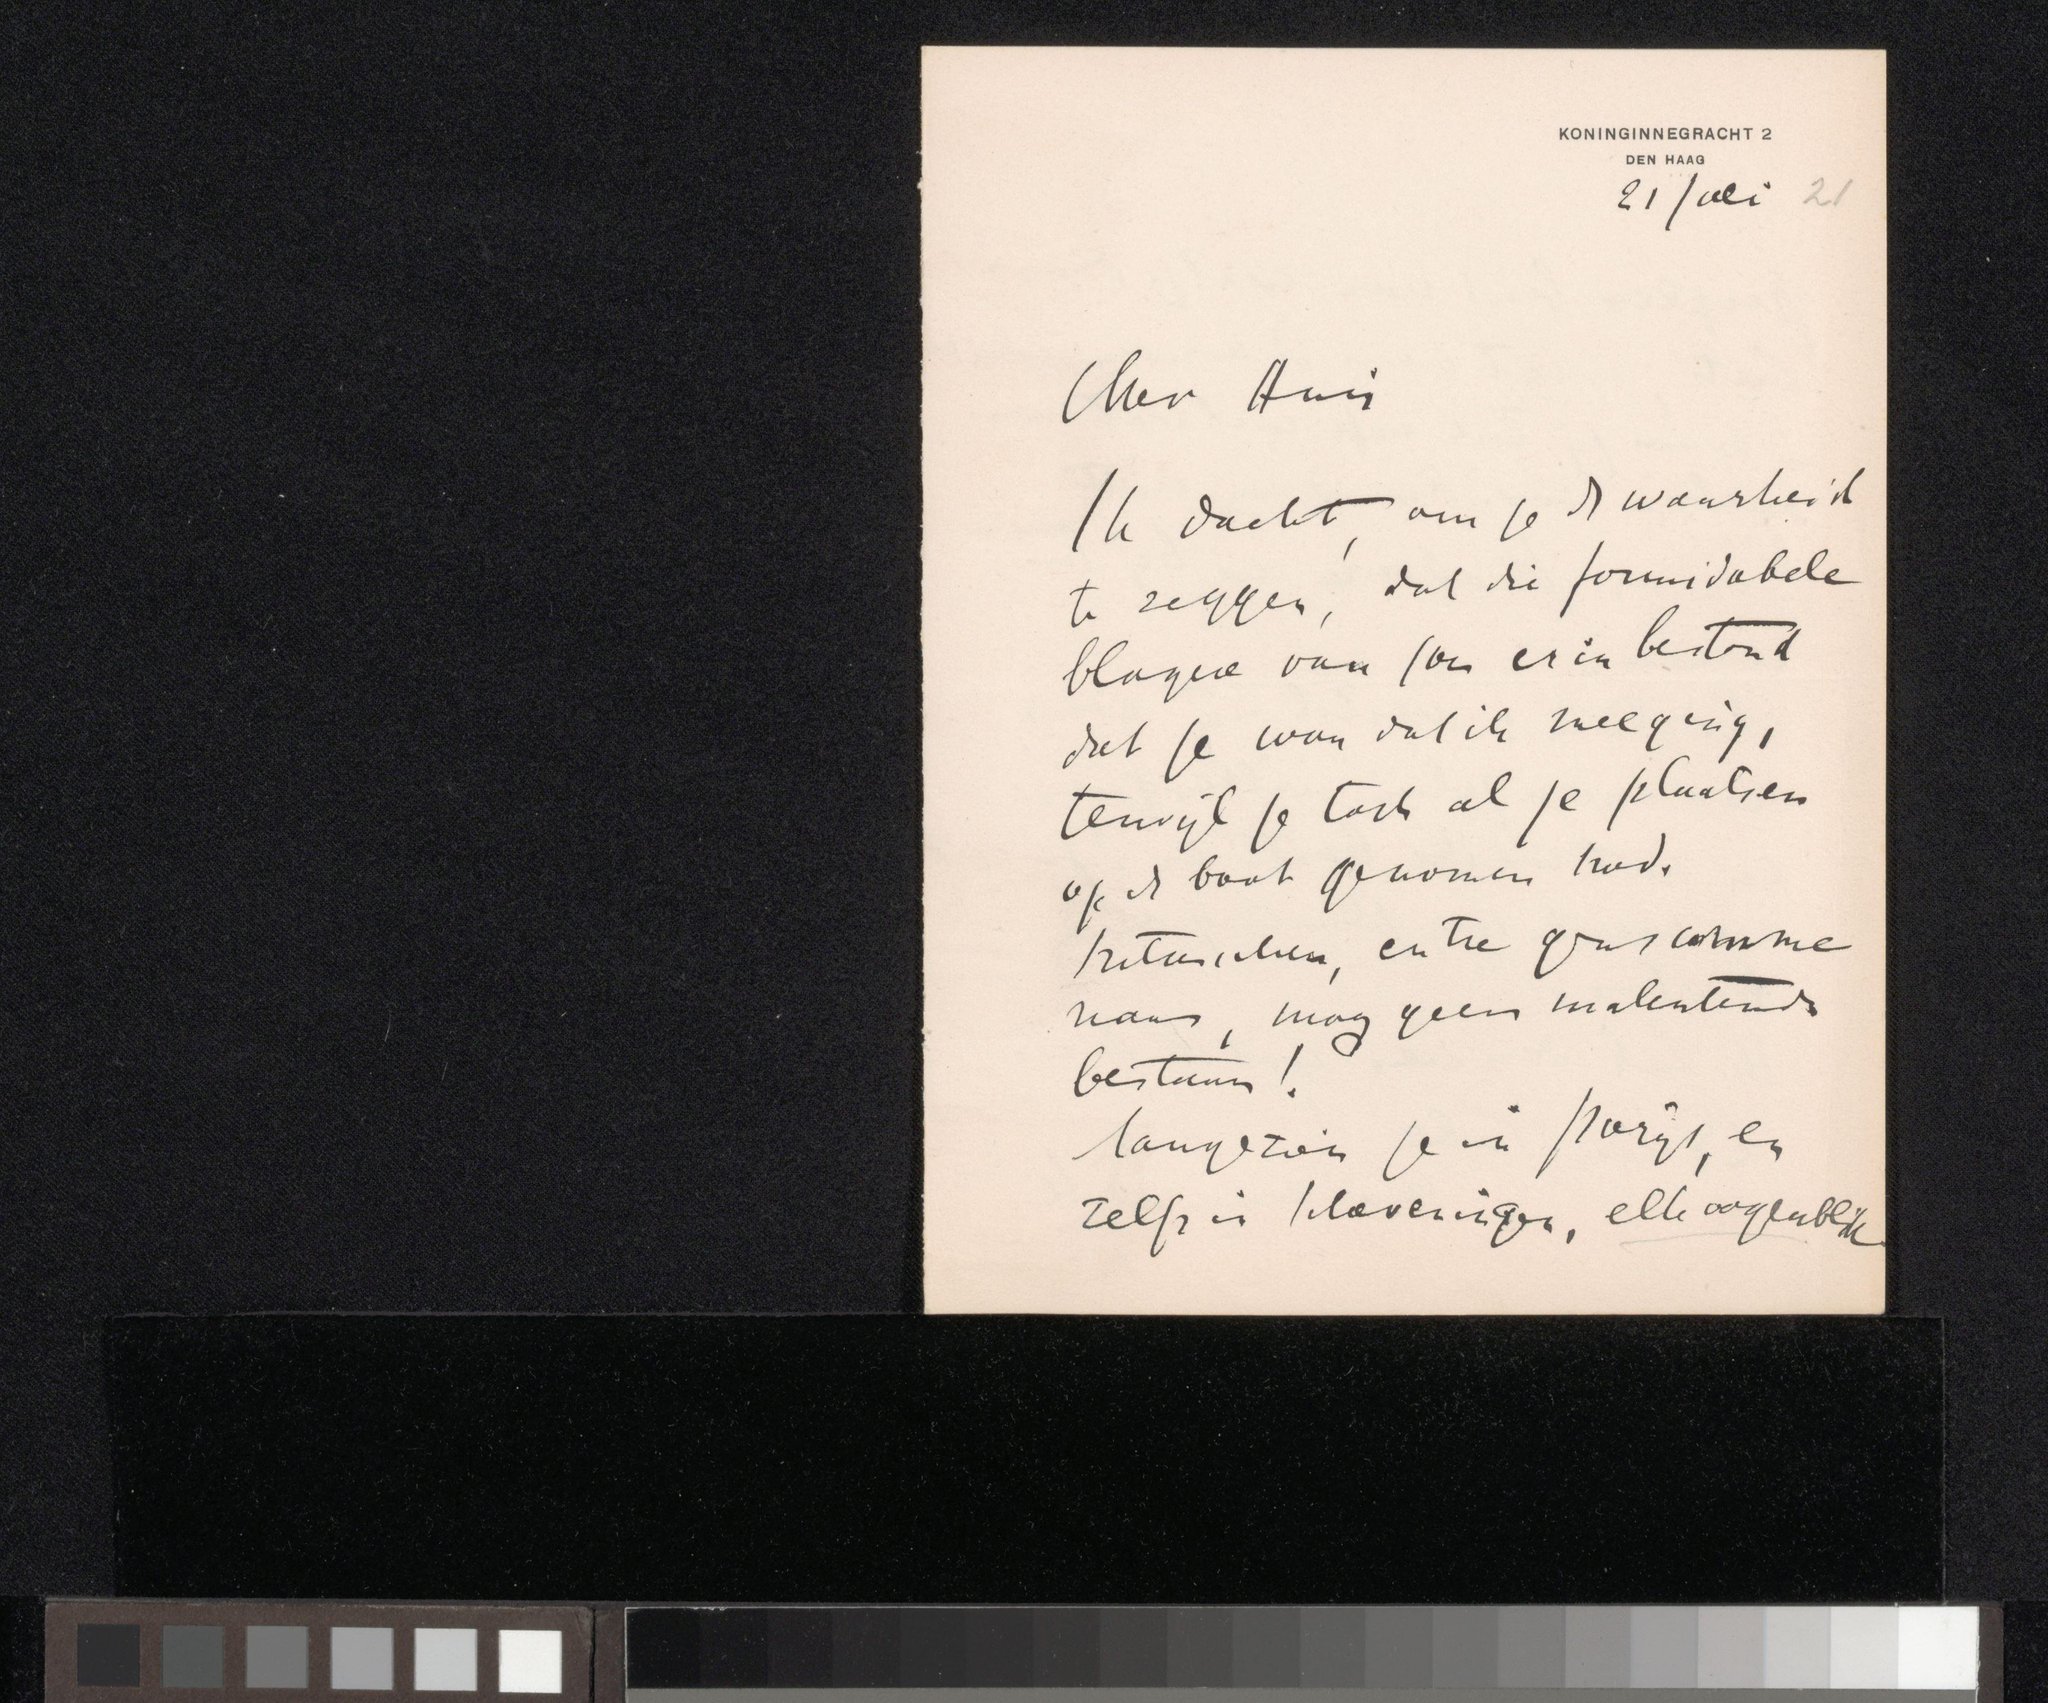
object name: letter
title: Brief aan Jan Veth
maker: isaac israels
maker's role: draughtsman, painter, print maker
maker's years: 1865-1934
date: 1875-1925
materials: ink, paper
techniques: pen, printing, writing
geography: the hague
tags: dordrecht, amsterdam, painter, draughtsman, designer, jan veth, travelling; tourism, java, madura, paris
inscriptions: collector's mark: ‘RPK’